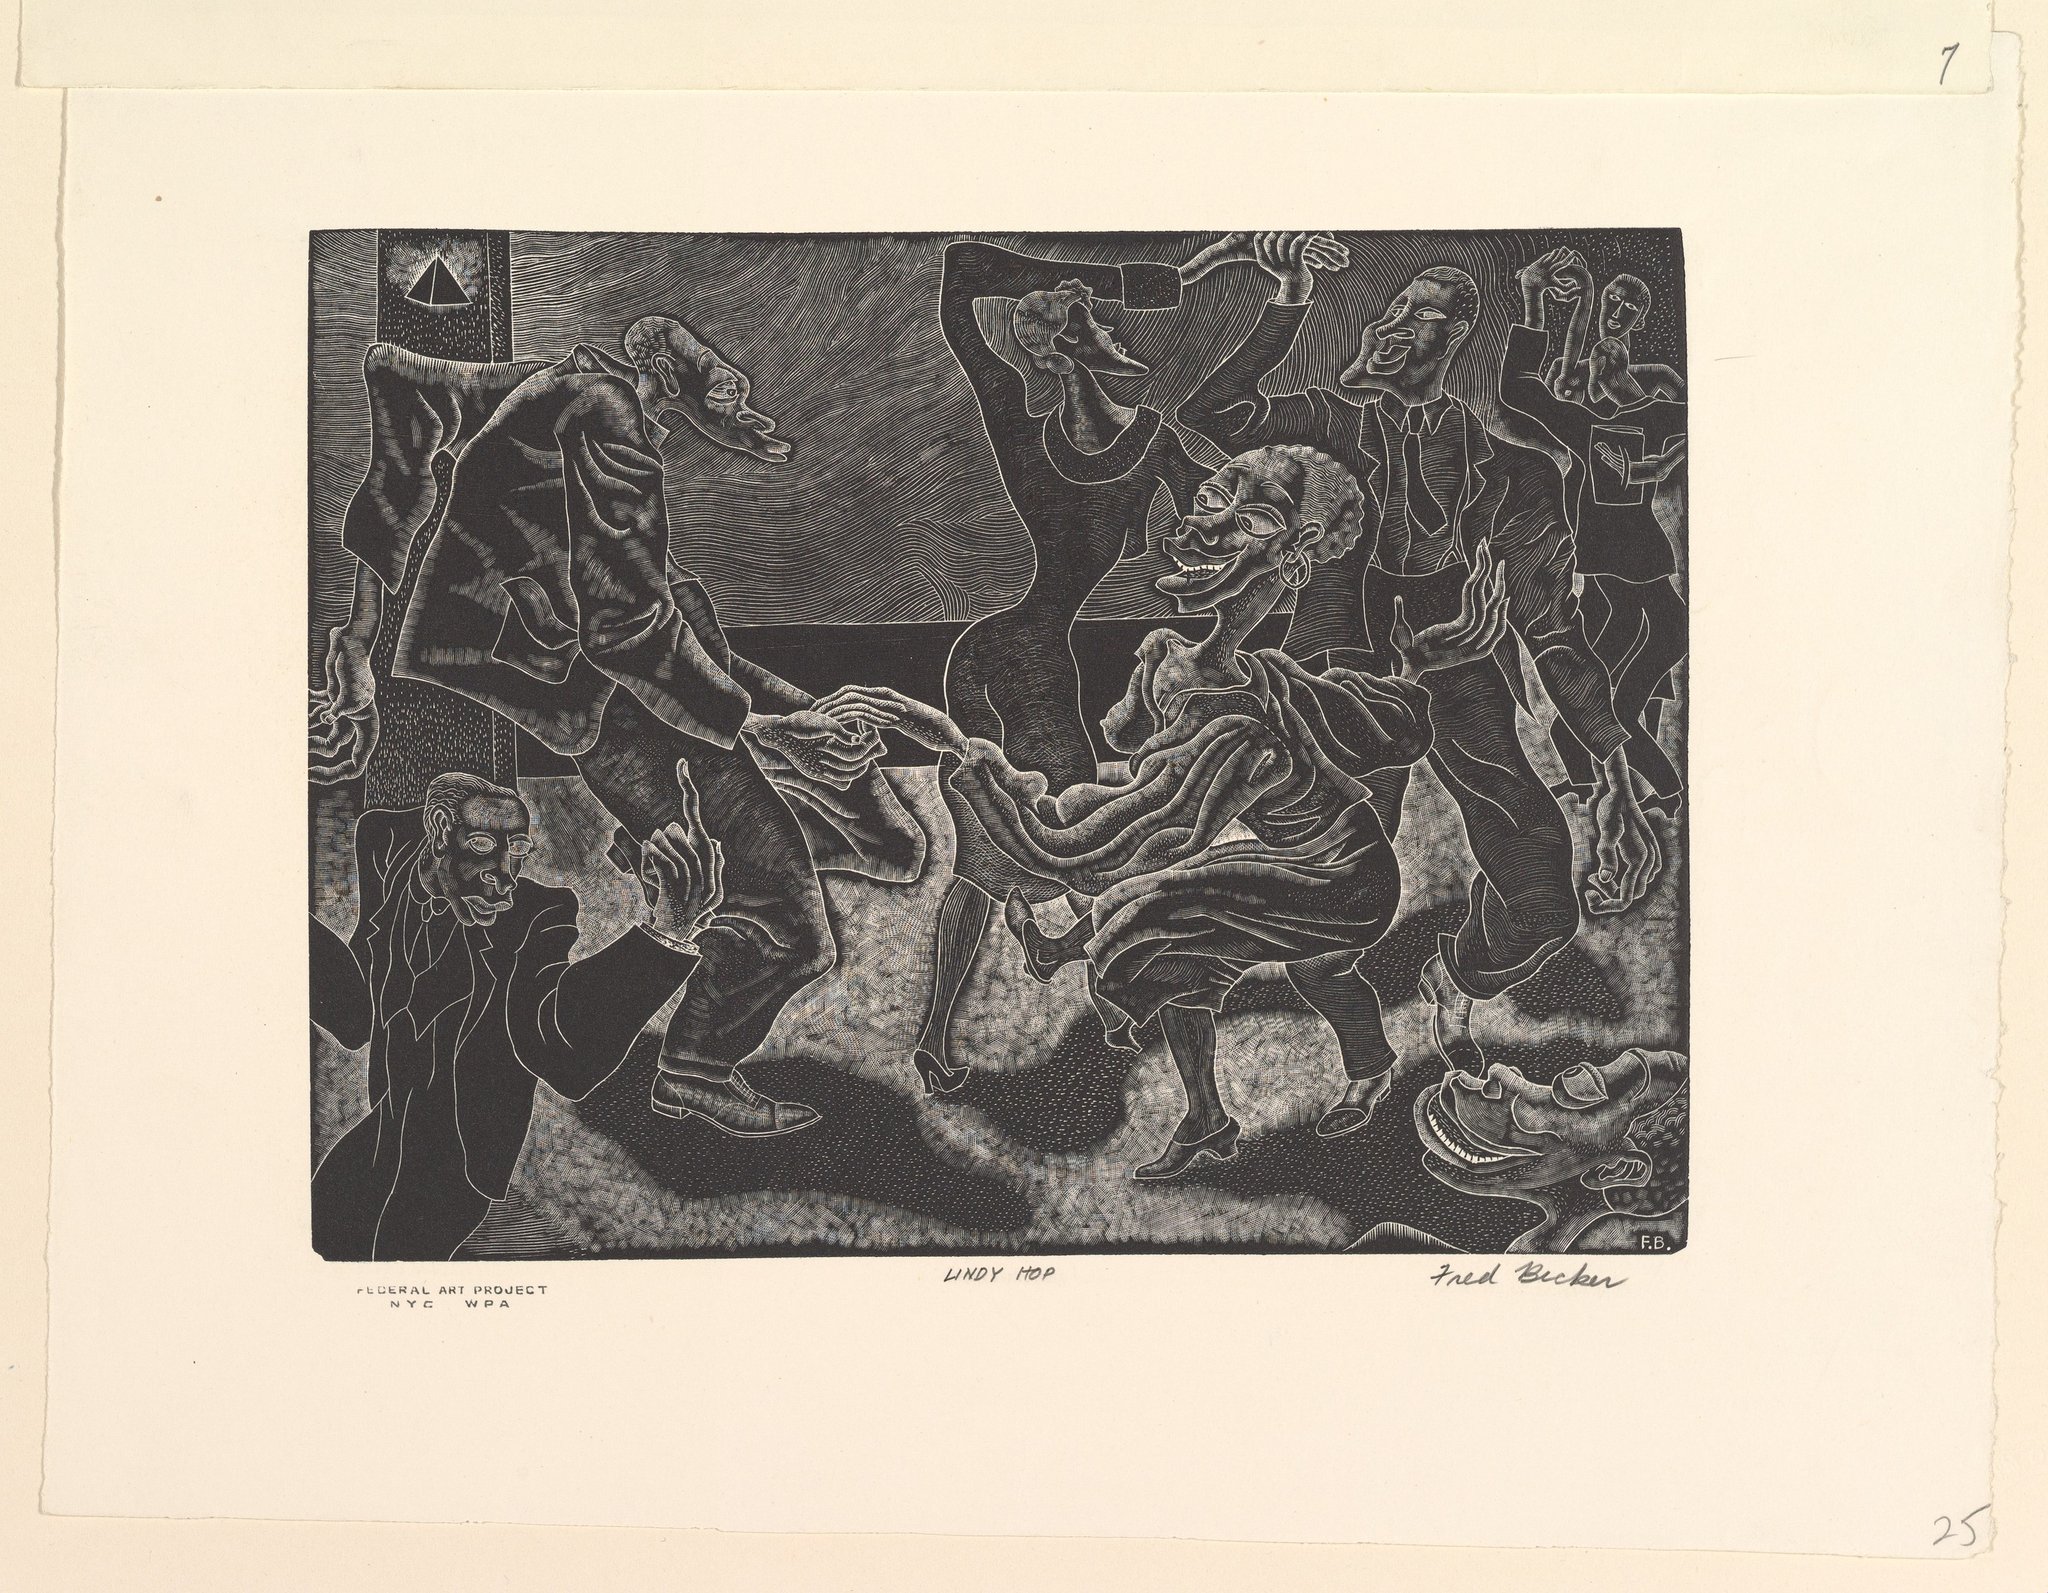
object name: print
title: Lindy Hop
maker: fred becker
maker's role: artist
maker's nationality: american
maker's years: 1913-2004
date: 1935-1940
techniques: engraving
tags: human figures